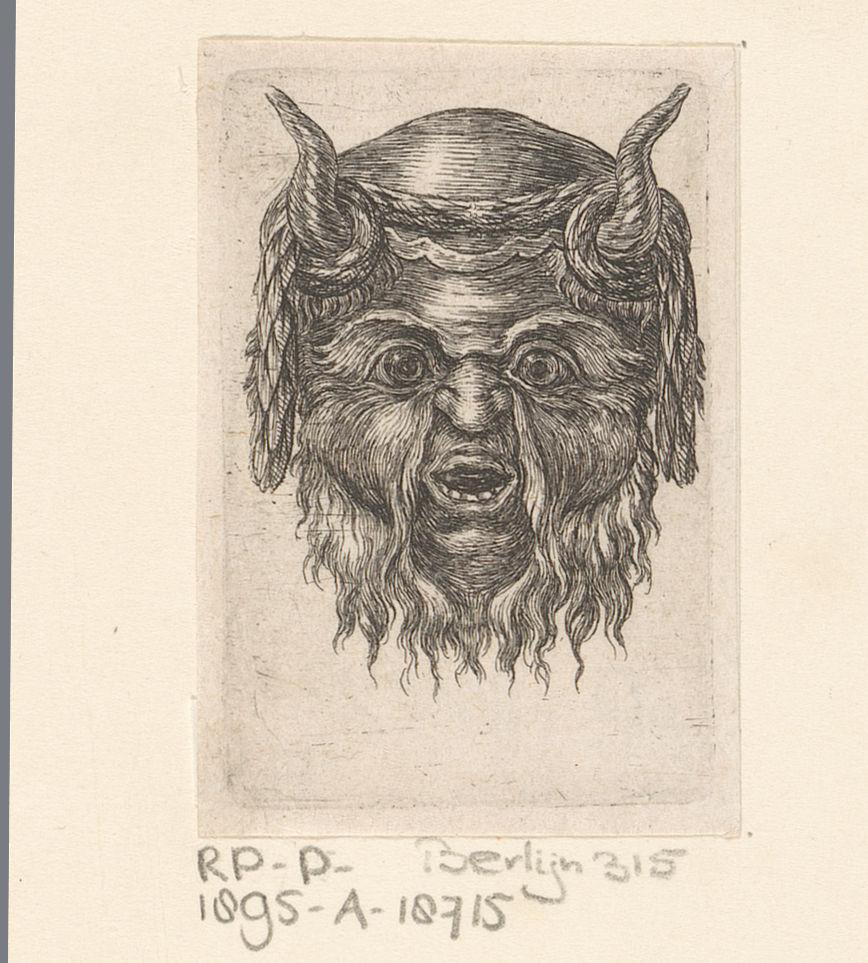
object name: ornament print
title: Masker met hoorns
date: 1626-1676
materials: paper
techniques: etching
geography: paris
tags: mask, mascaron ~ ornament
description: Mannelijk masker met hoorns met guirlande en baard.